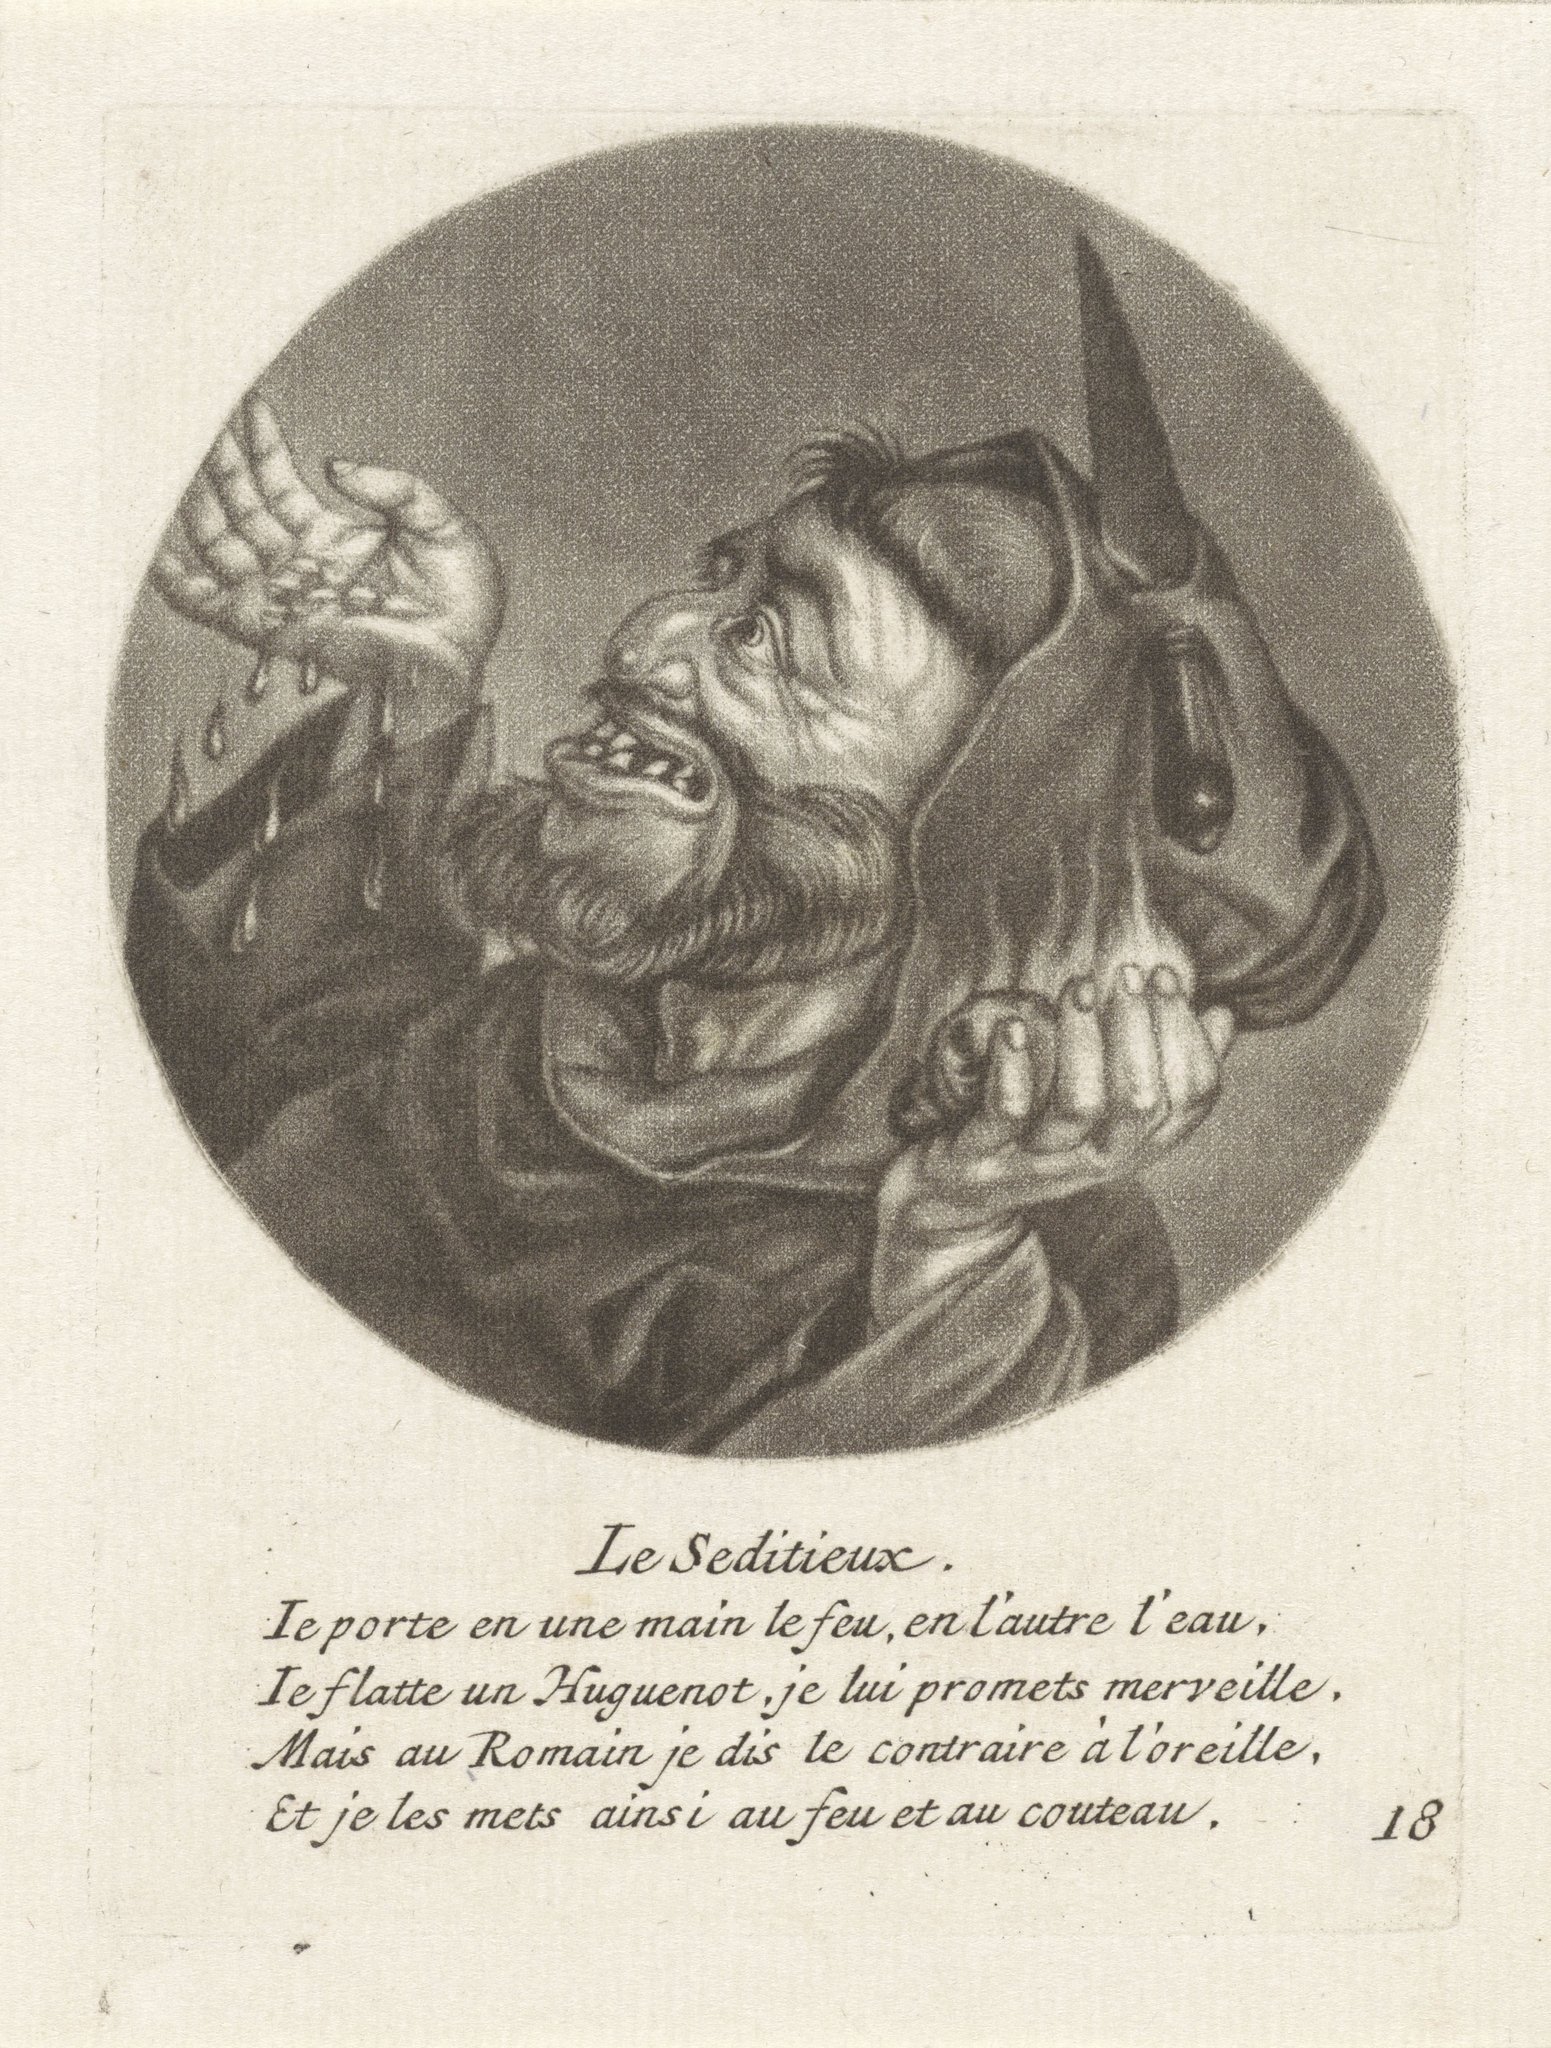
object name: print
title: Karikaturen op de Franse geestelijkheid onder Lodewijk XIV, (B)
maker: jacob gole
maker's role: print maker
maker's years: 1660-1724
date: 1670-1724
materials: paper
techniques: engraving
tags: water (one of the four elements), monk(s), friar(s), tools, aids, implements ~ crafts and industries: knife, flame, political caricatures and satires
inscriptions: collector's mark: Lugt 2228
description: Een opstandige monnik met een mes in zijn kap en vuur in de ene hand en water in de andere. De prent maakt deel uit van een serie met karikaturen van de Franse geestelijkheid onder Lodewijk XIV.